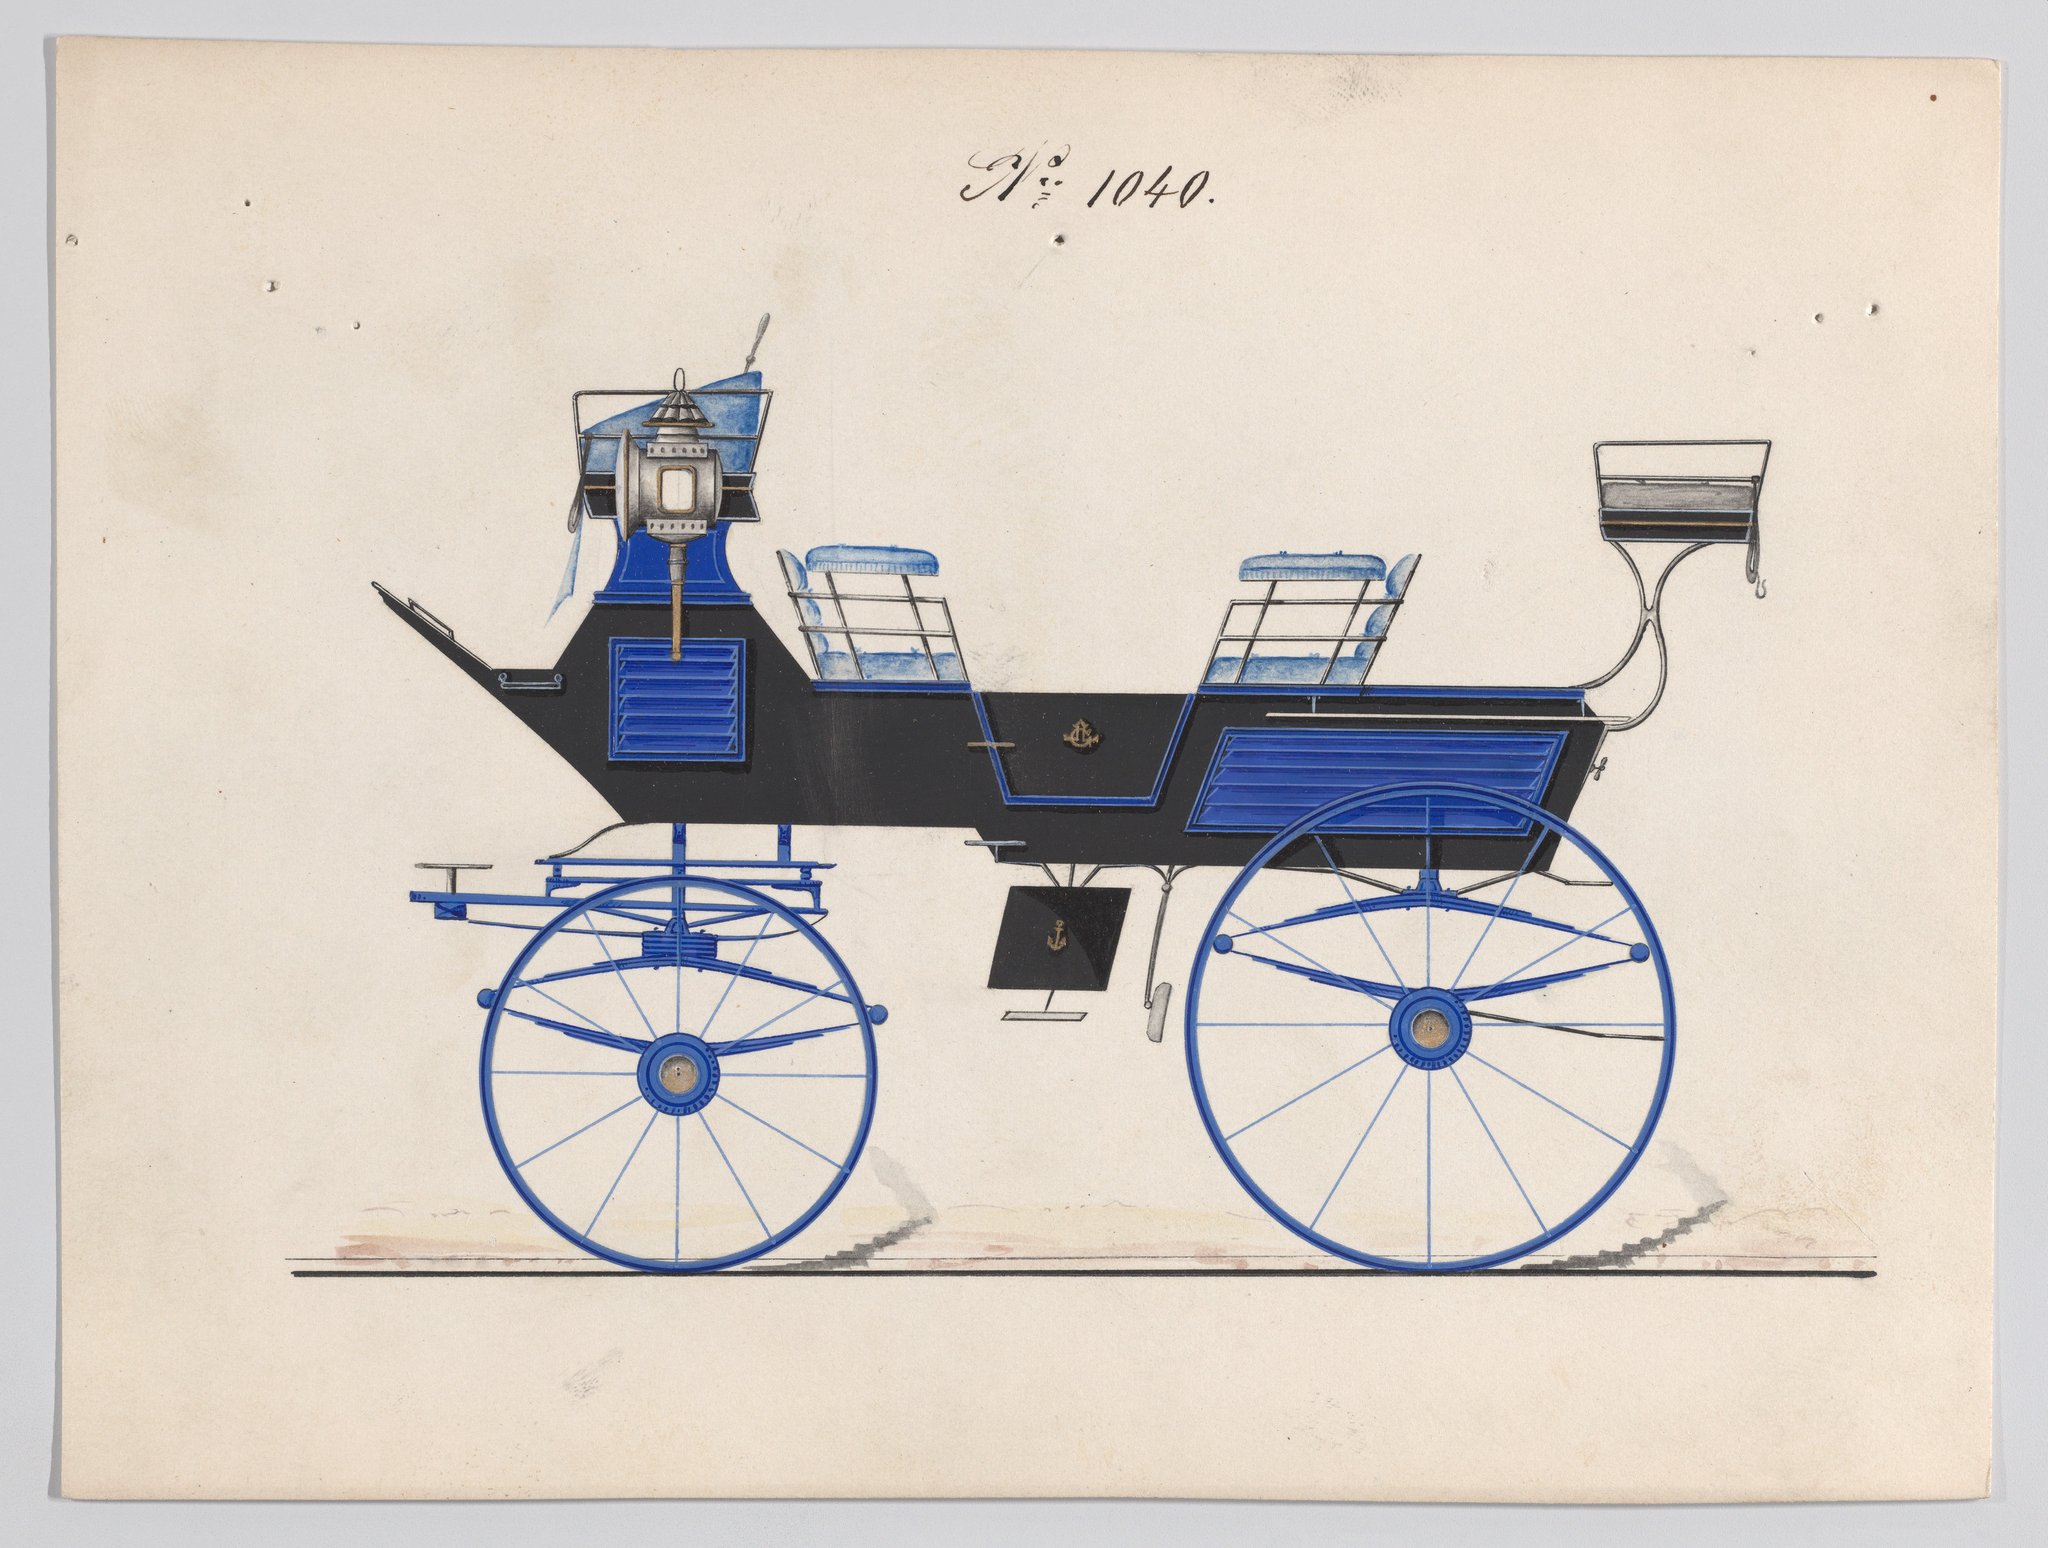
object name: drawing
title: Drag #1040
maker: brewster & co.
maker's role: manufacturer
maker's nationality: american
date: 1850-1870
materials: gouache, gum arabic, ink, watercolor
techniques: pen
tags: carriages